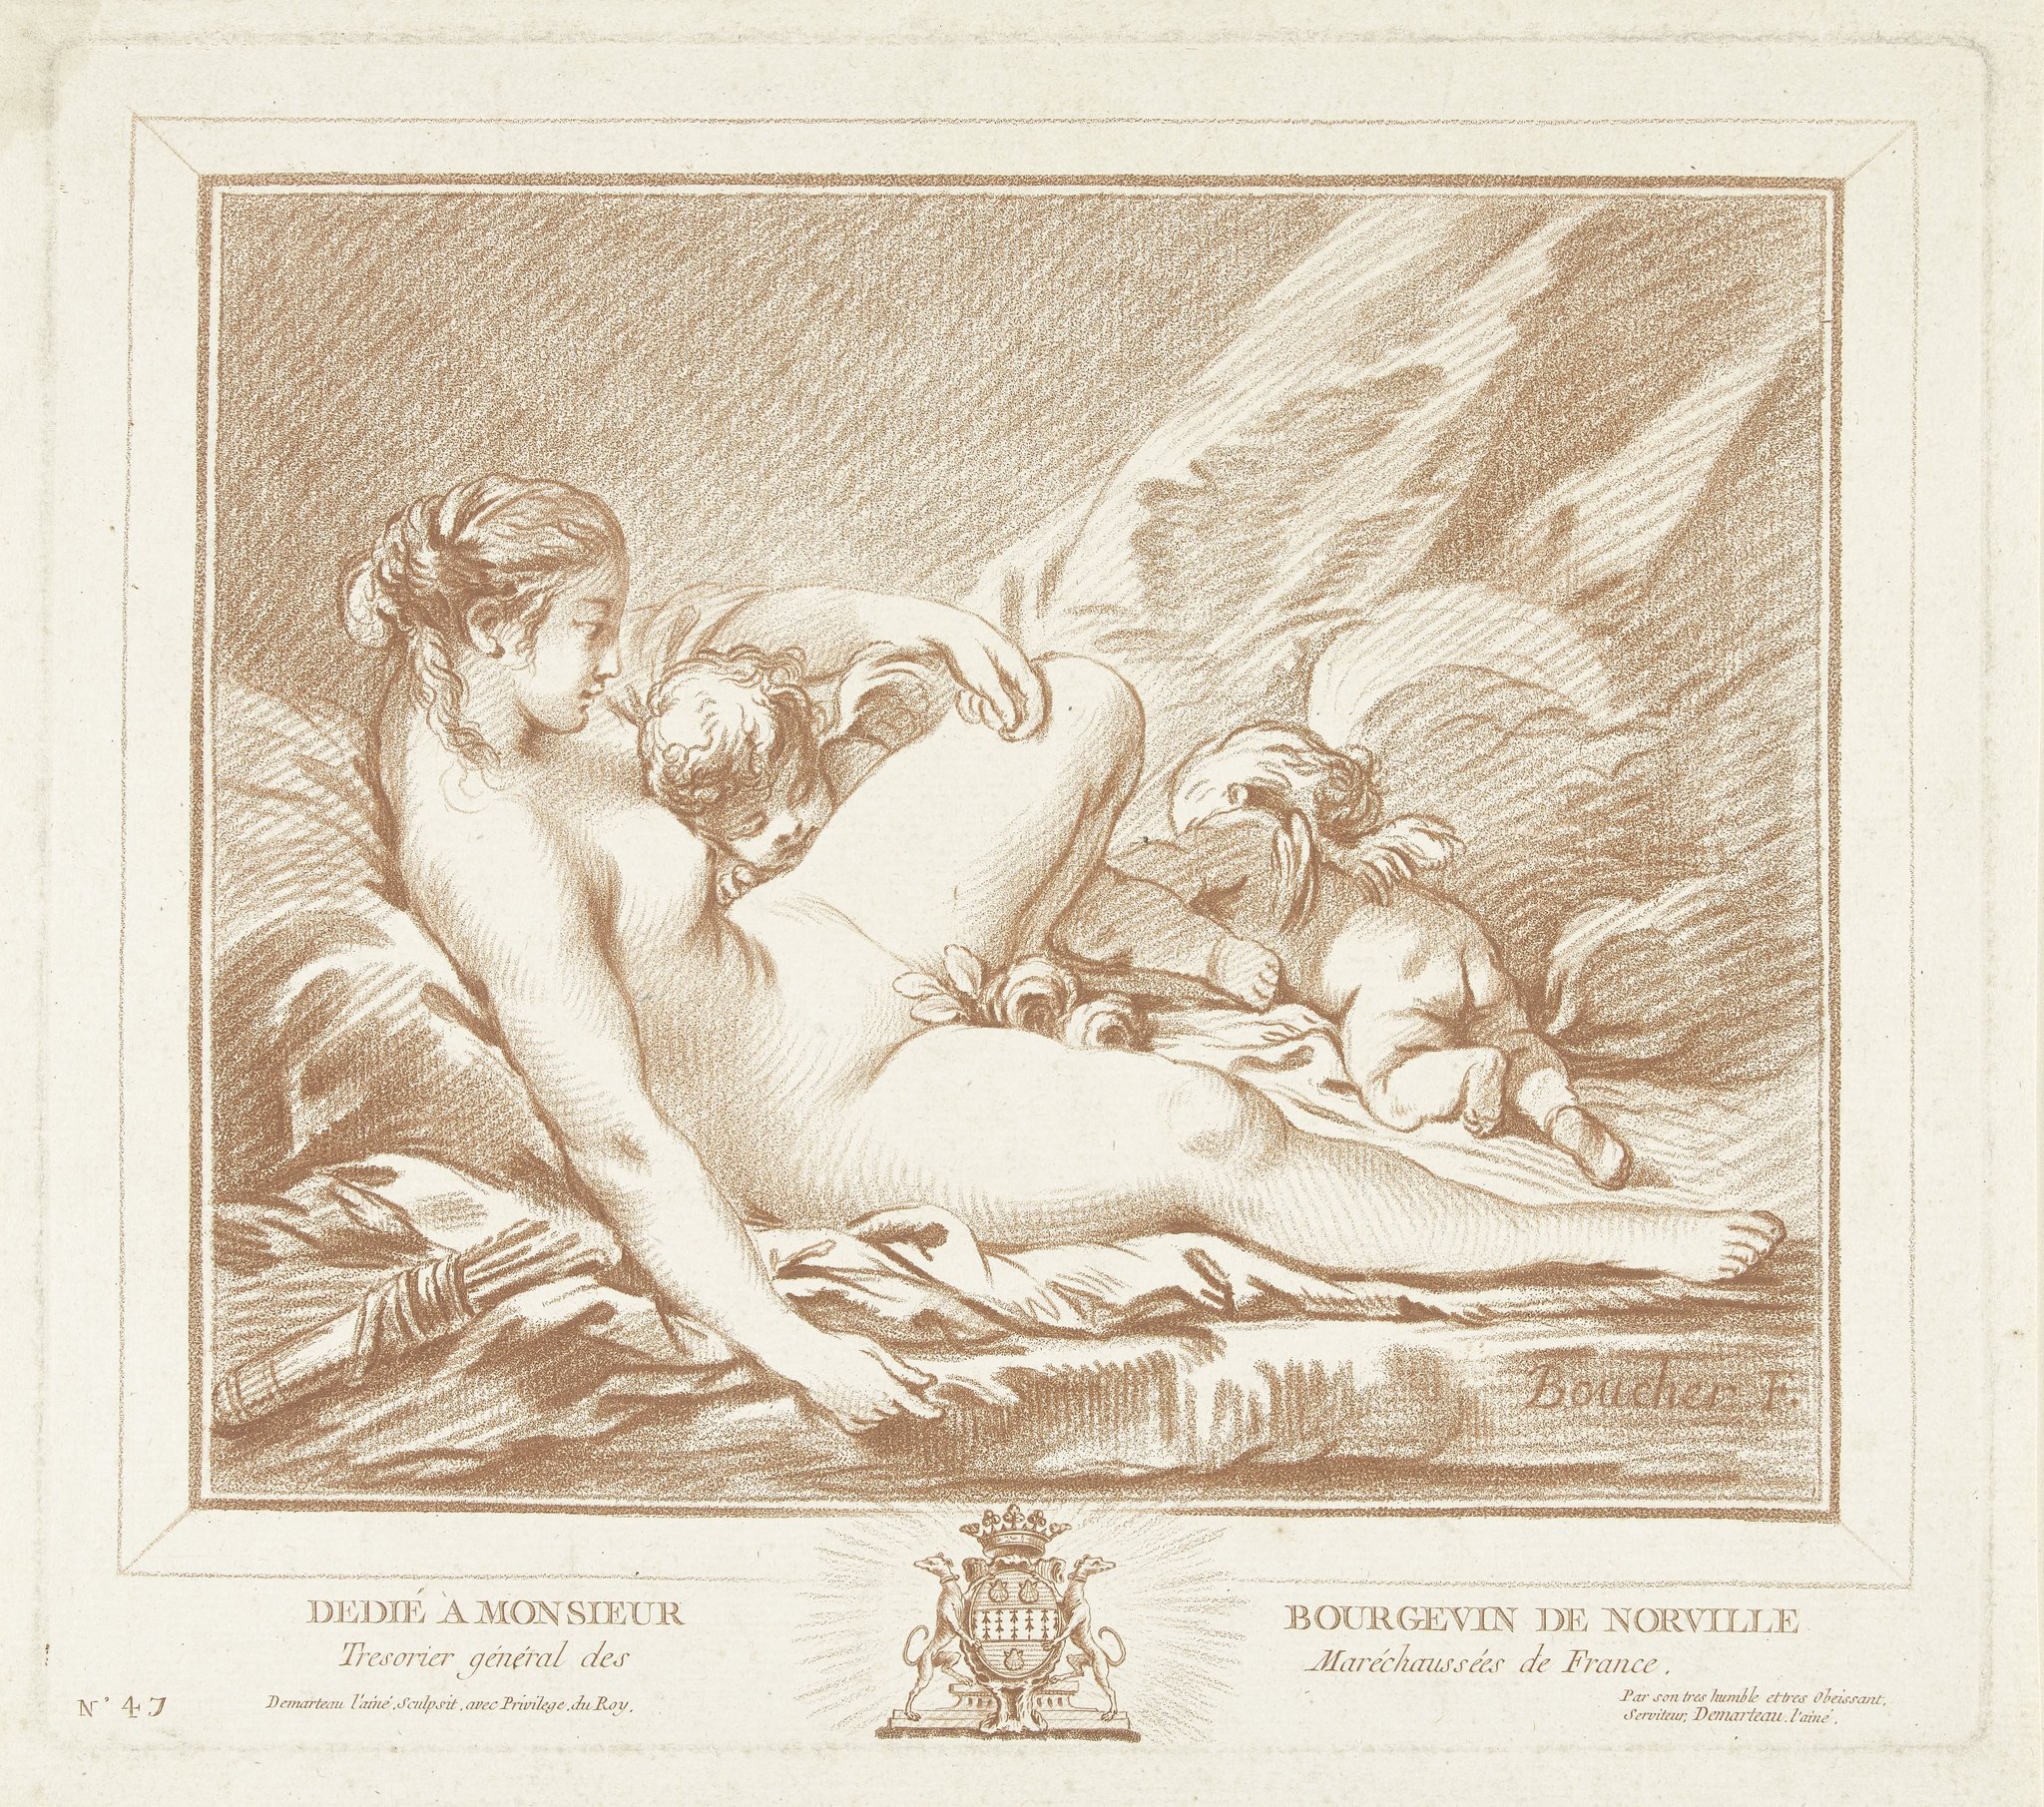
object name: print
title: Liggende Venus met Amor en Anteros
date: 1732-1776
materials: paper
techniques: printmaking, etching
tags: river, venus and cupid (cupid not being mere attribute)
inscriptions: collector's mark: Lugt 2228